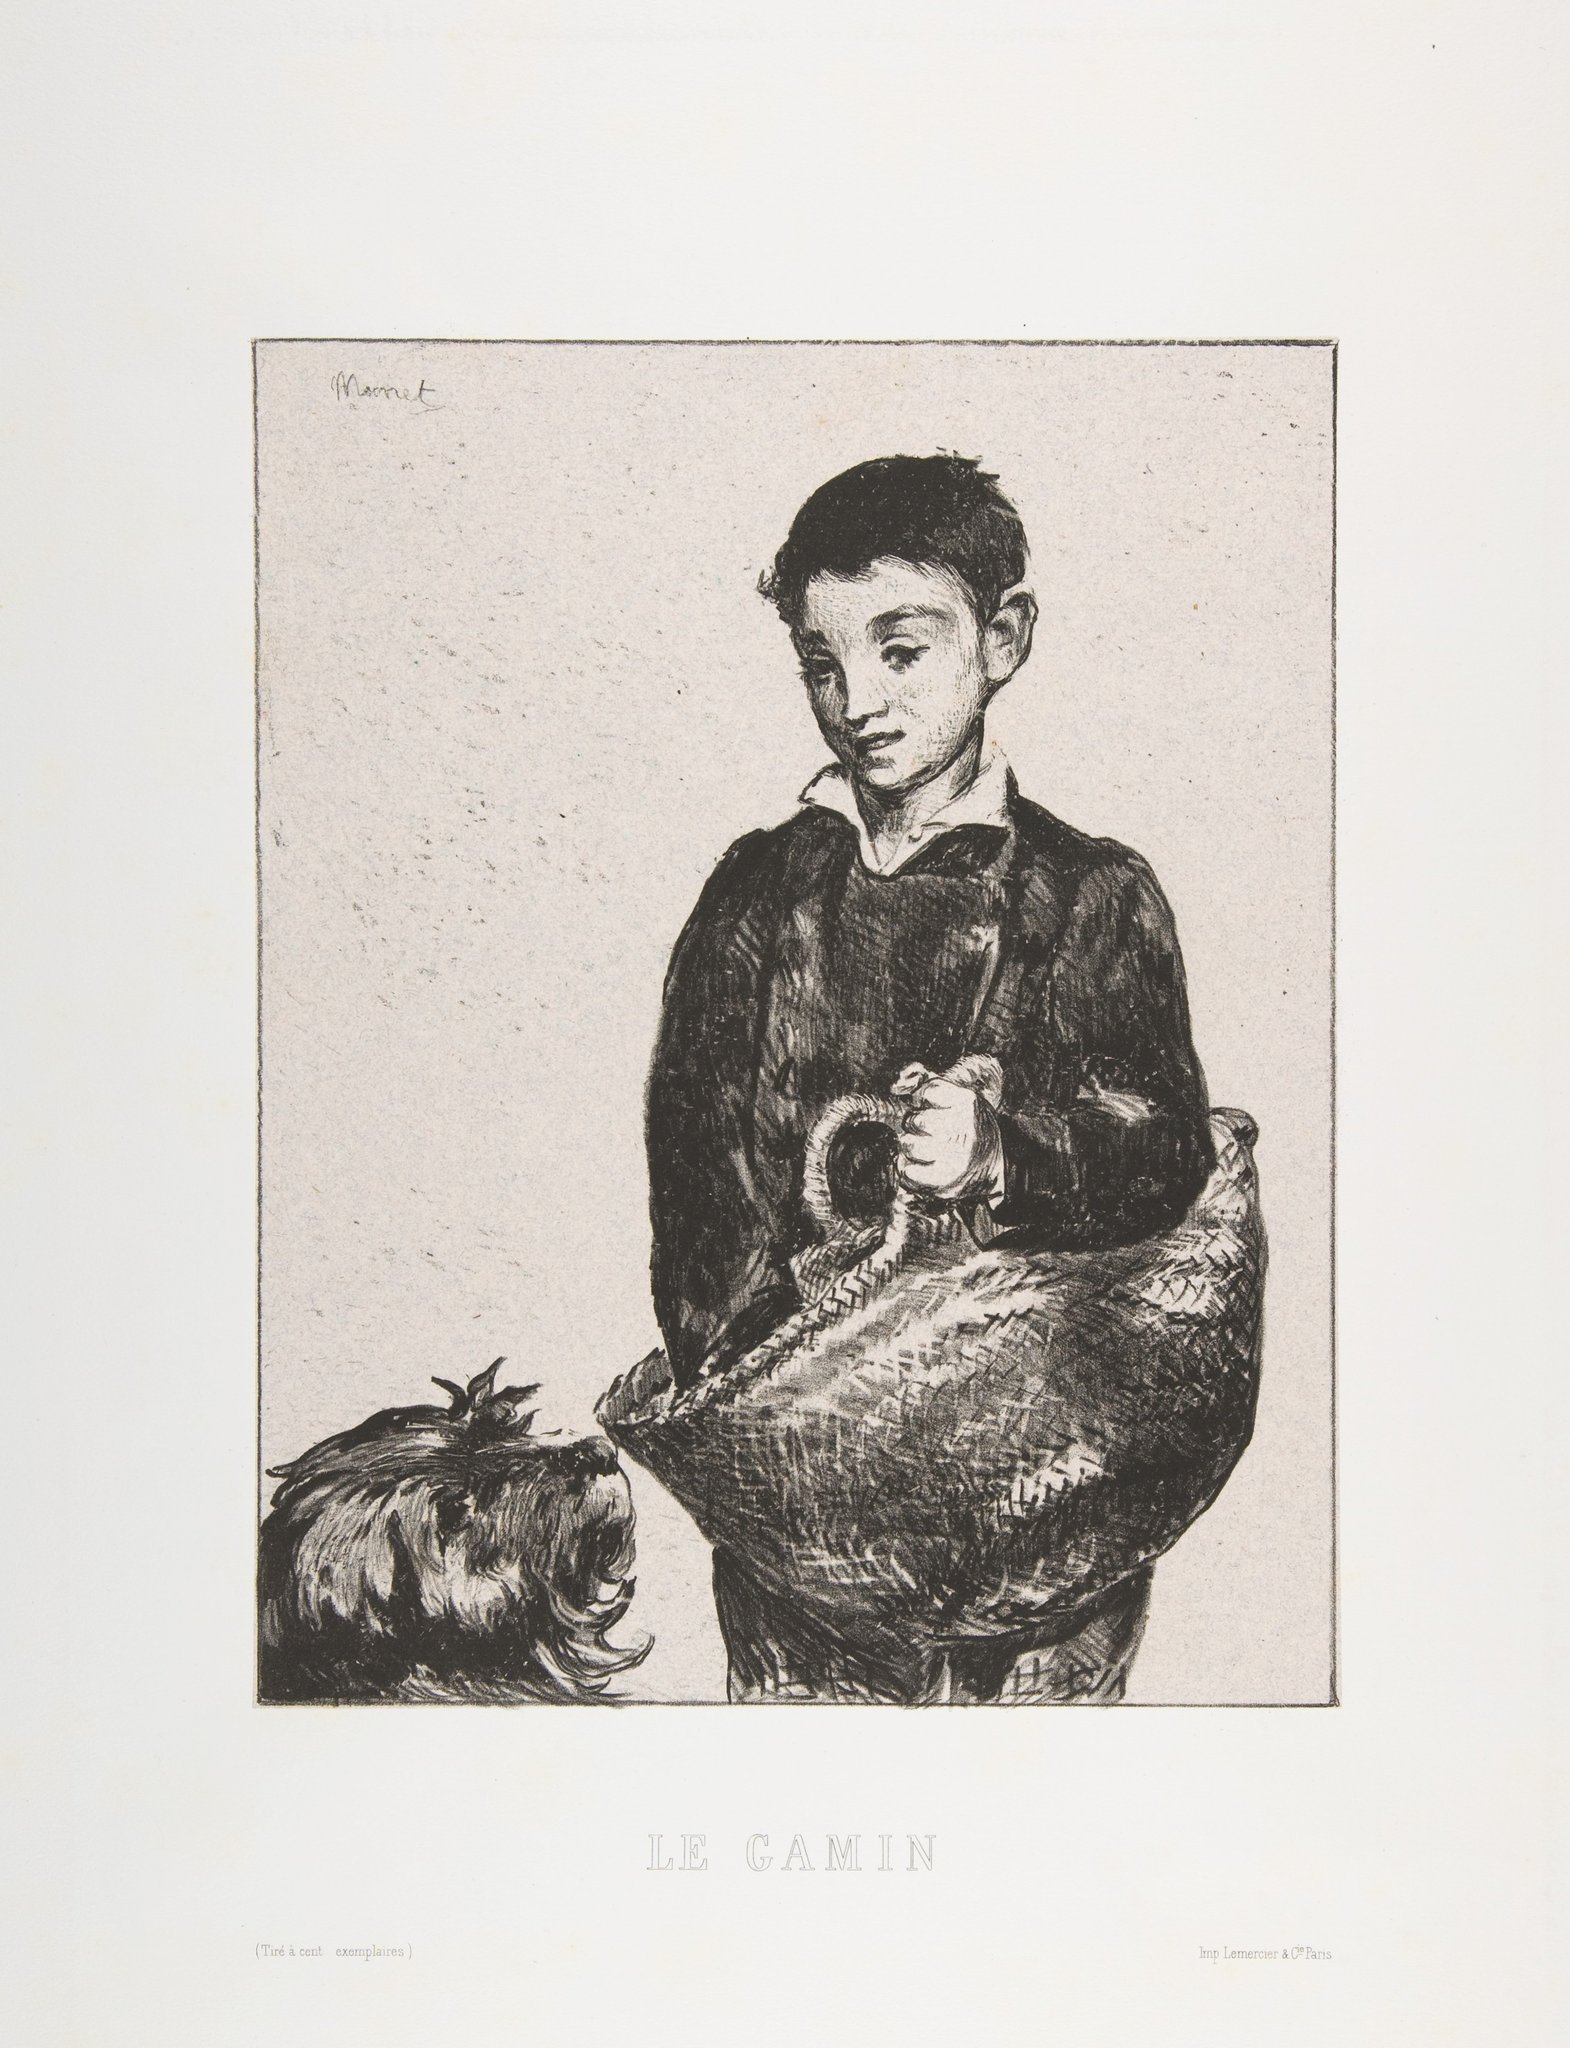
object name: print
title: The Urchin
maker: édouard manet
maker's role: artist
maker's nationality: french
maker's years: 1832-1883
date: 1868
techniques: printmaking, lithograph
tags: boys